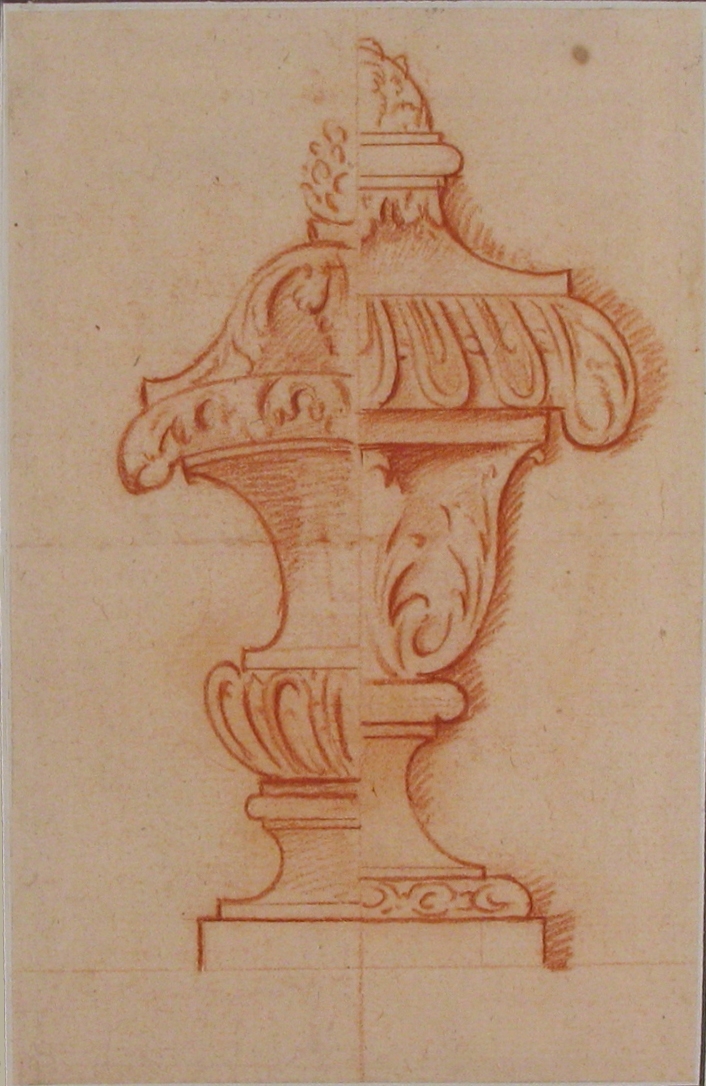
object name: drawing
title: Design for Vase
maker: anonymous, french, 18th century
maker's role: artist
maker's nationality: french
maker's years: 1700-1800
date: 1760-1775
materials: chalk